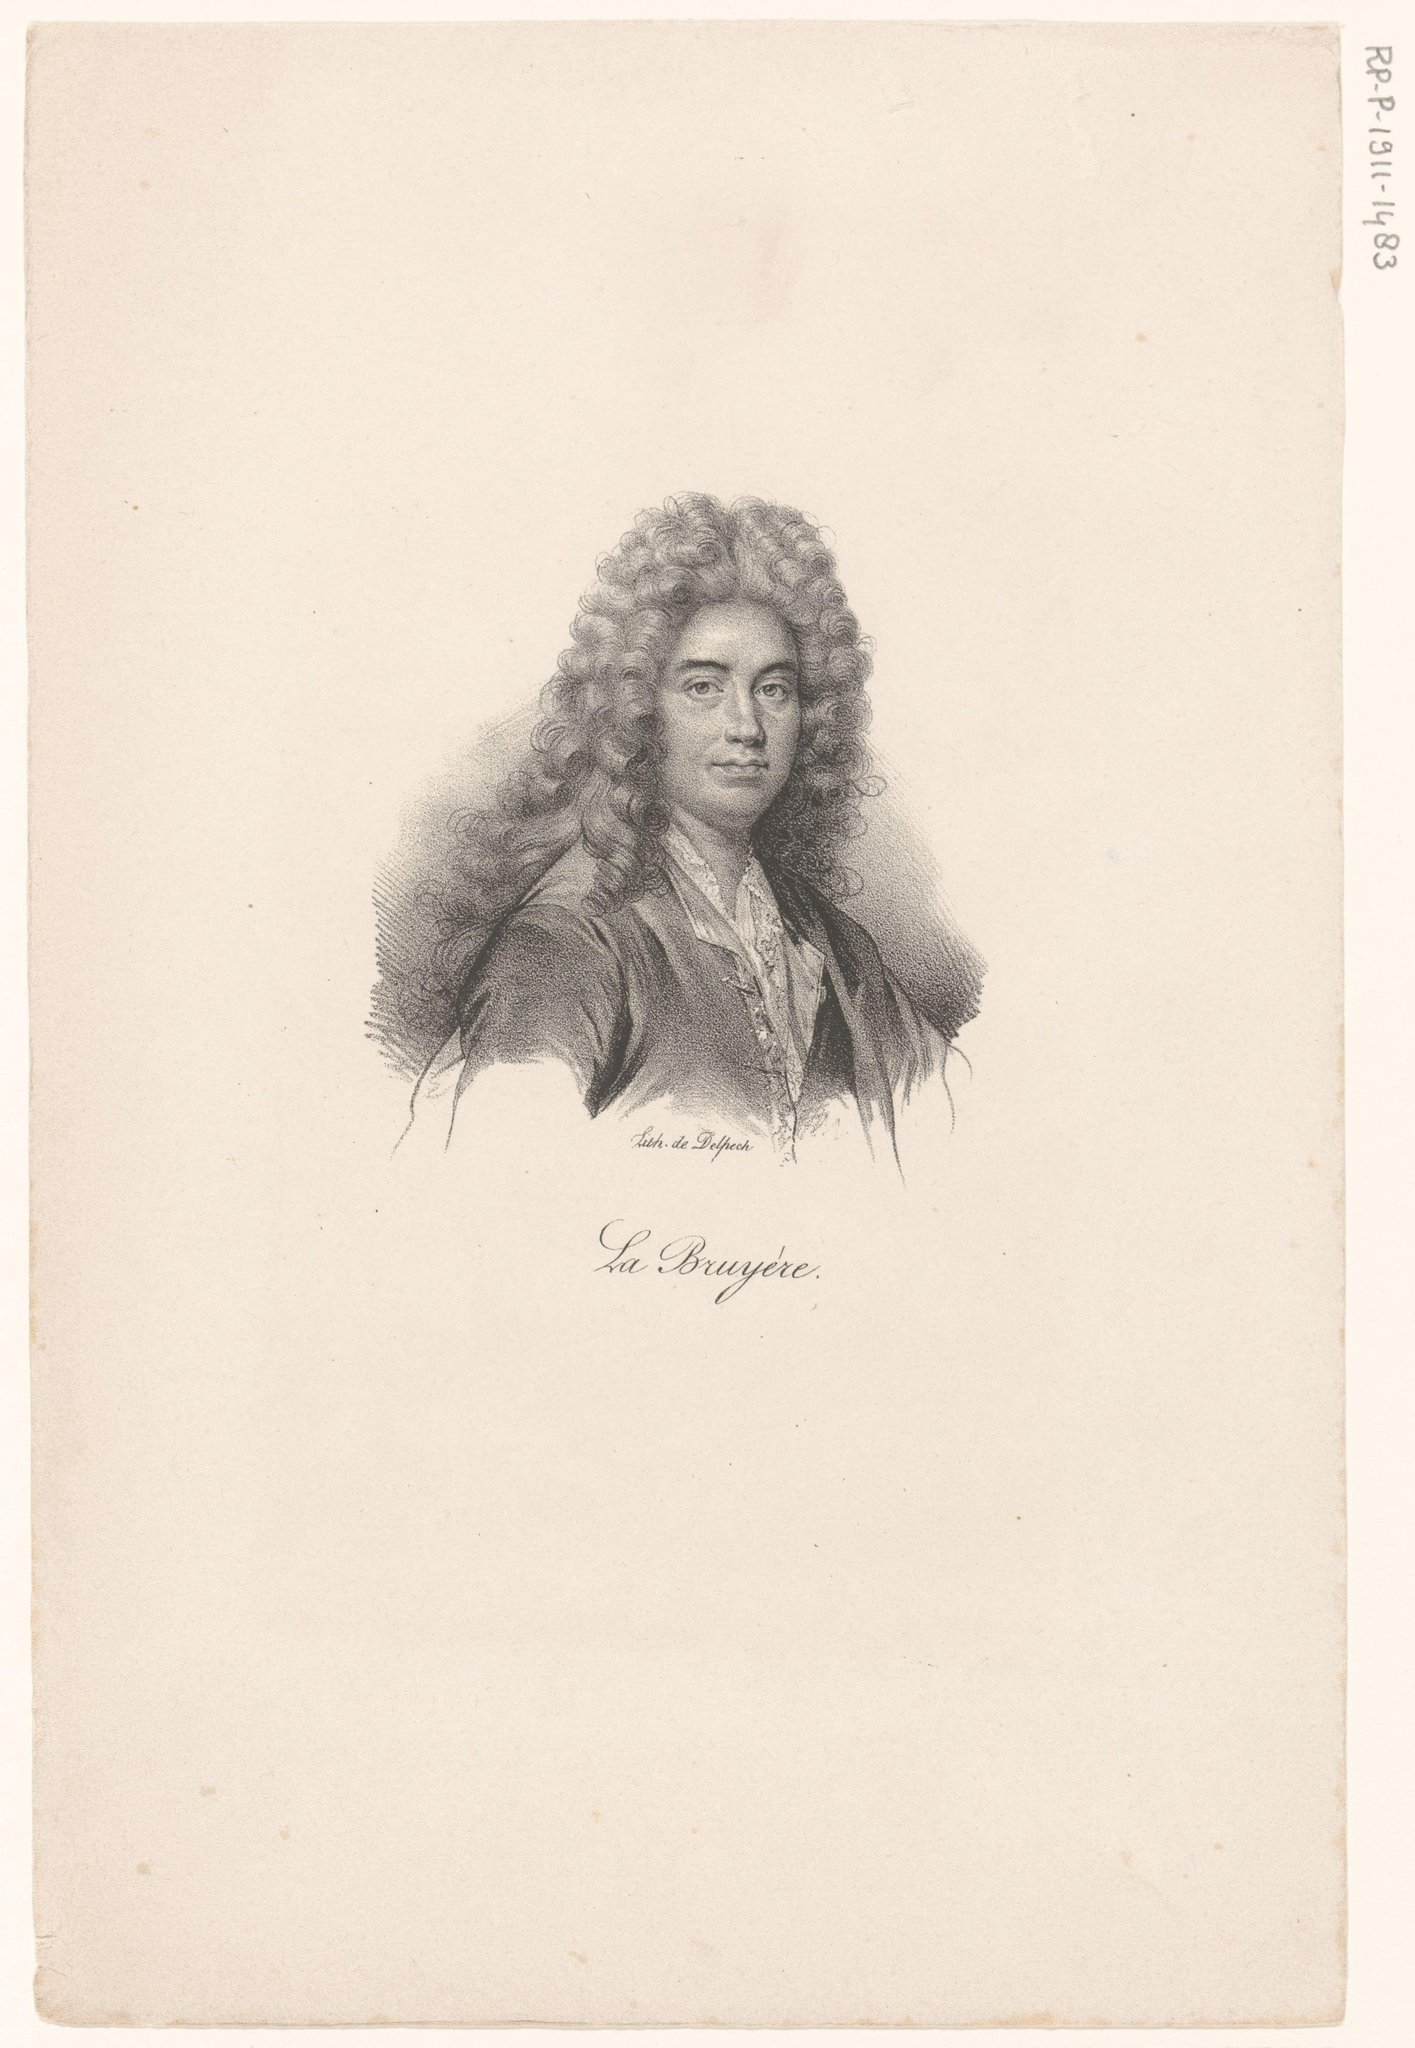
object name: print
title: Portret van Jean de La Bruyère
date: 1818-1842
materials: paper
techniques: lithograph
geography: paris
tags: historical persons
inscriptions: collector's mark: Lugt 2228a